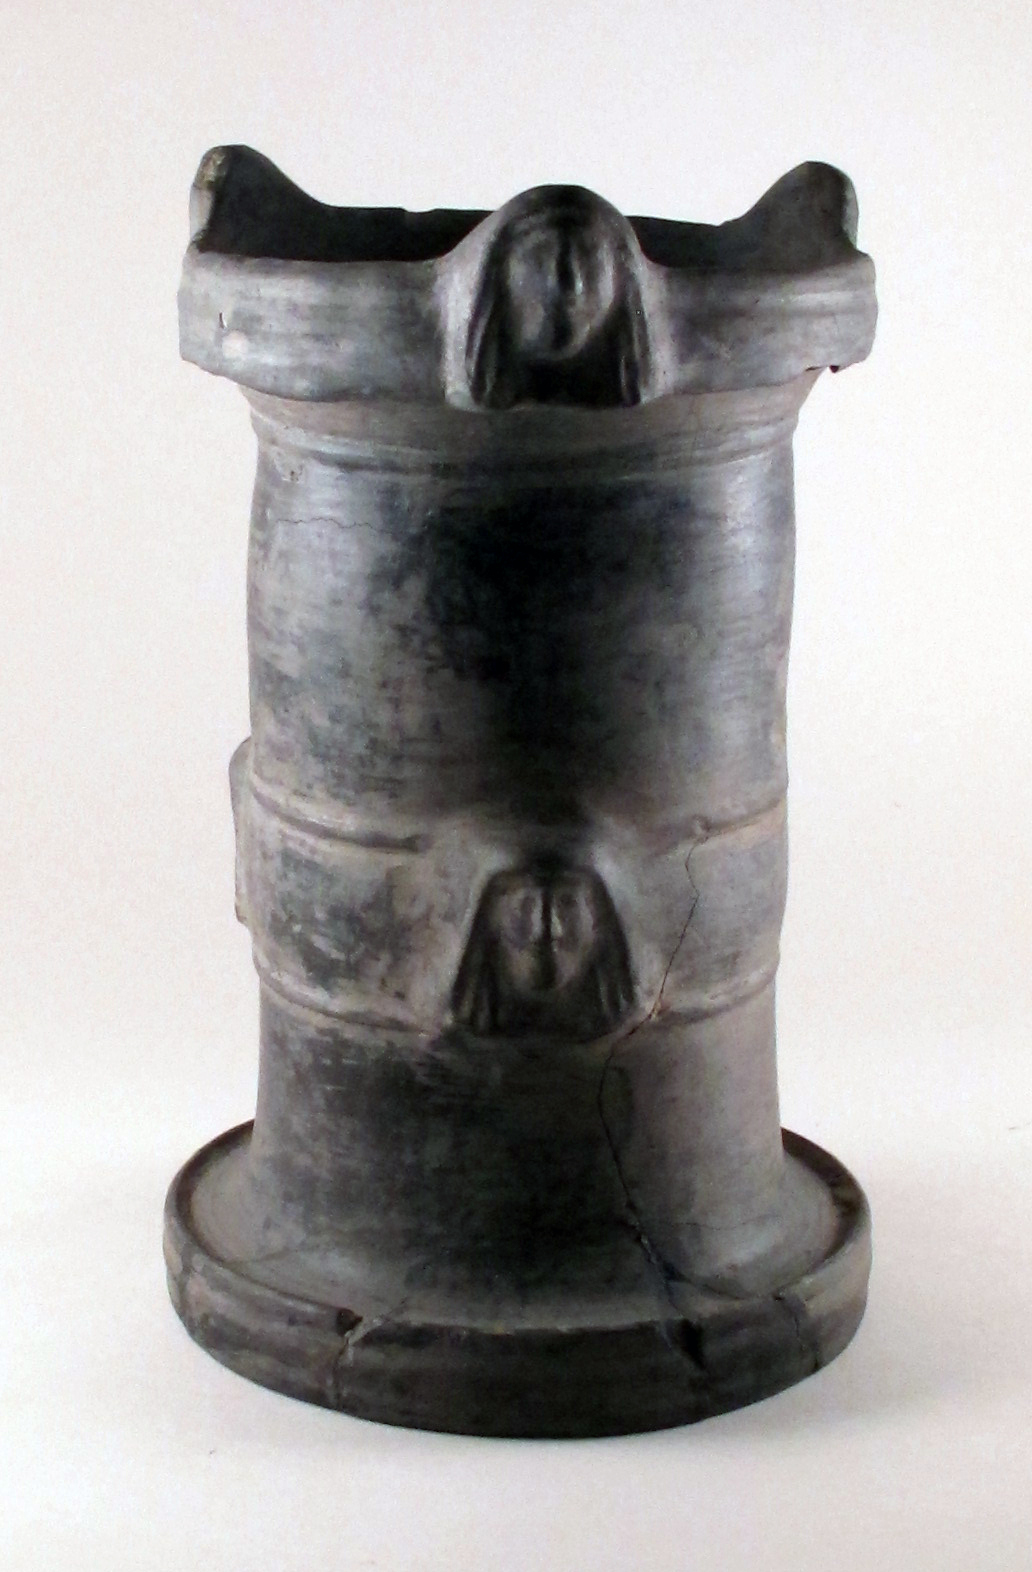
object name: stand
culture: etruscan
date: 550-500 BCE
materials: terracotta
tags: heads